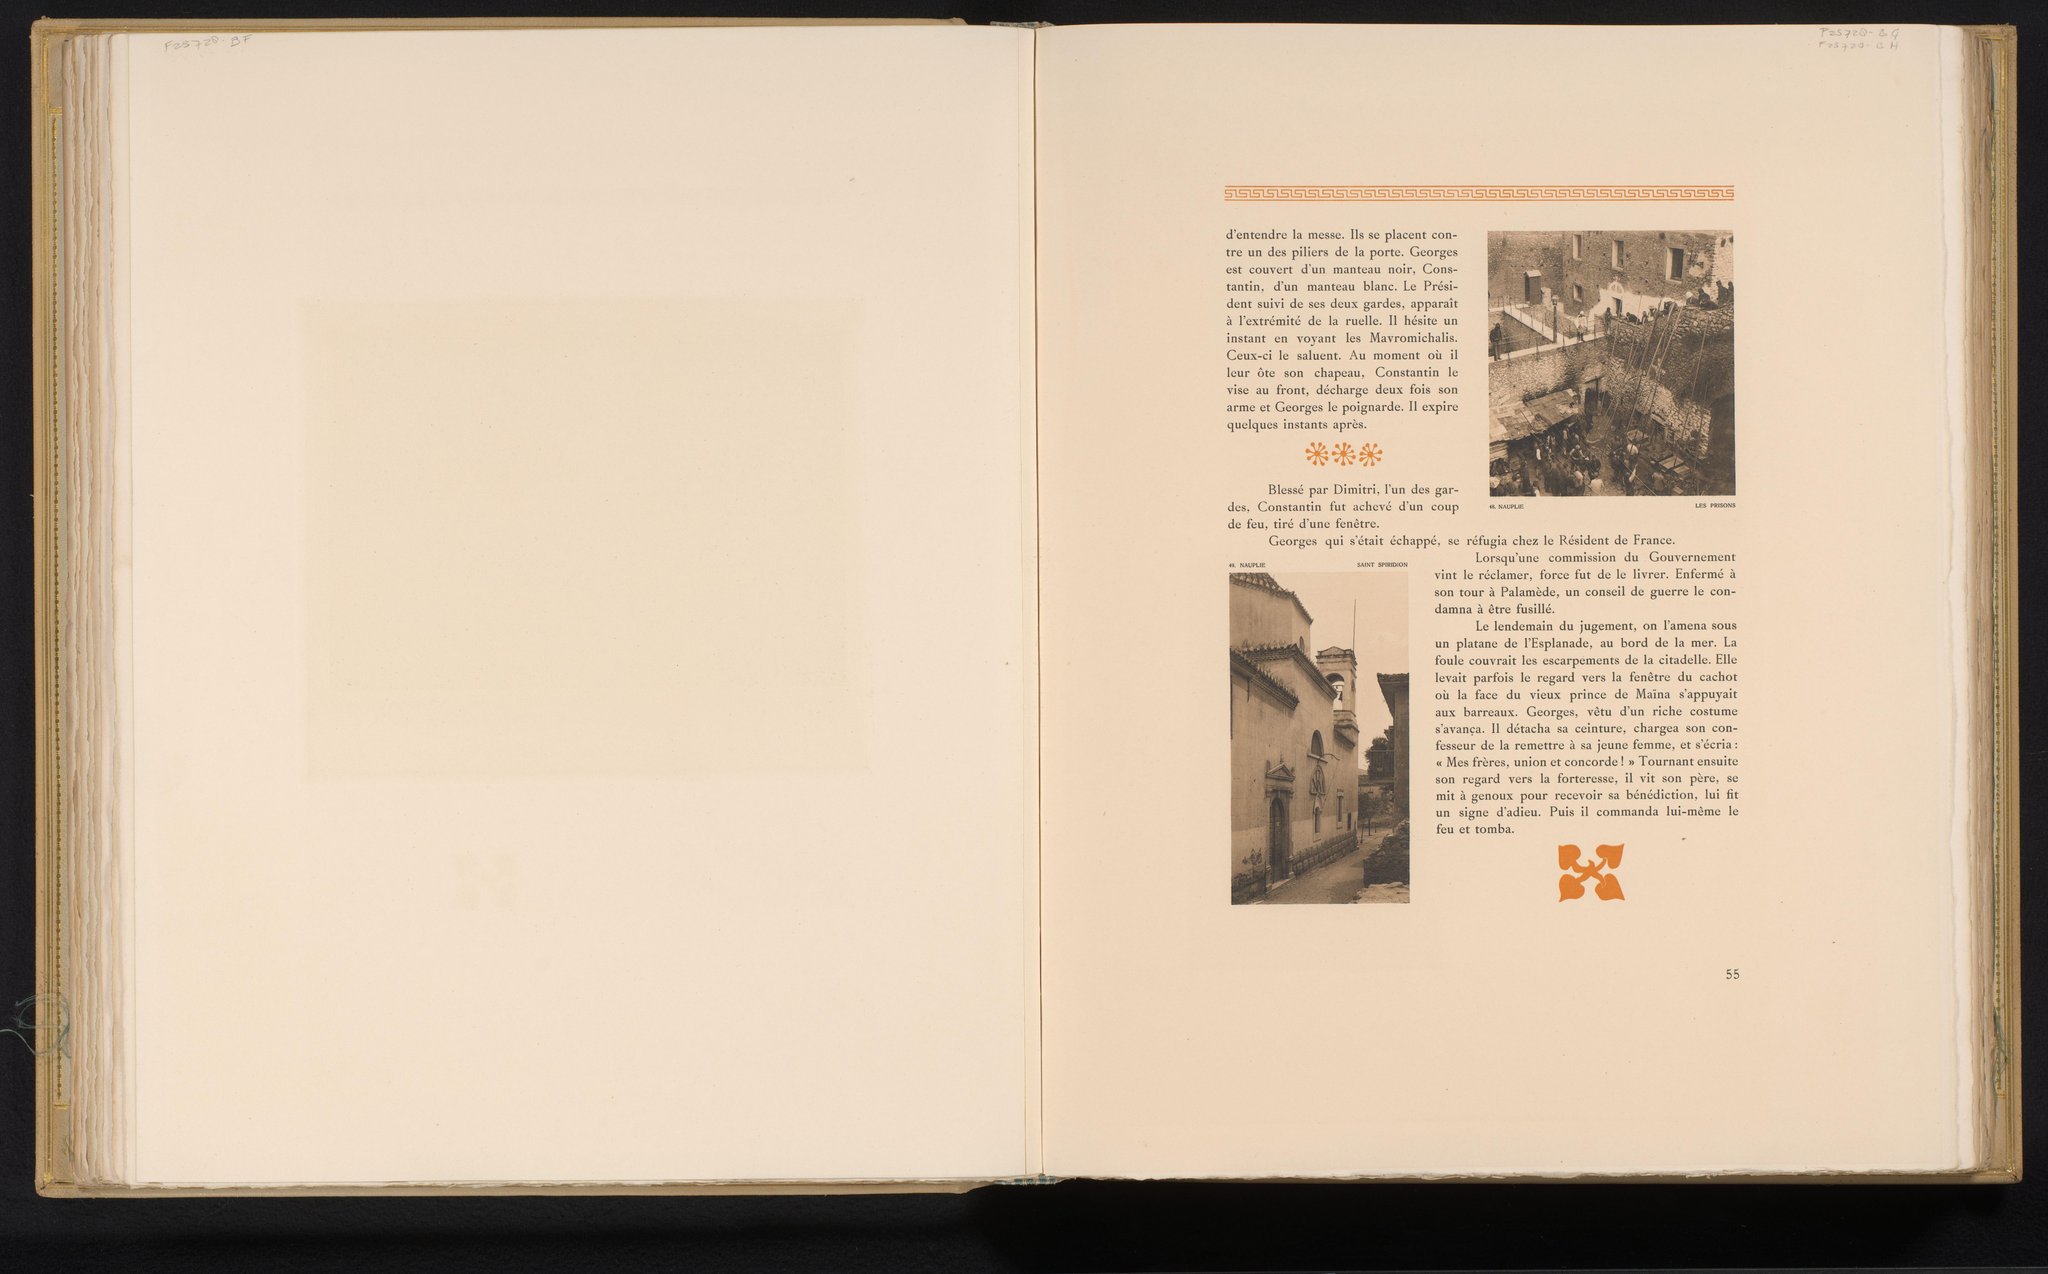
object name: page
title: Nauplie, les prisons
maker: frédéric boissonnas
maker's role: fotograaf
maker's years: 1858-1946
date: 1905-1910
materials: paper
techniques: photograph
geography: nauplion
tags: (prisoners) in the prison yard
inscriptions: number: ‘48.’